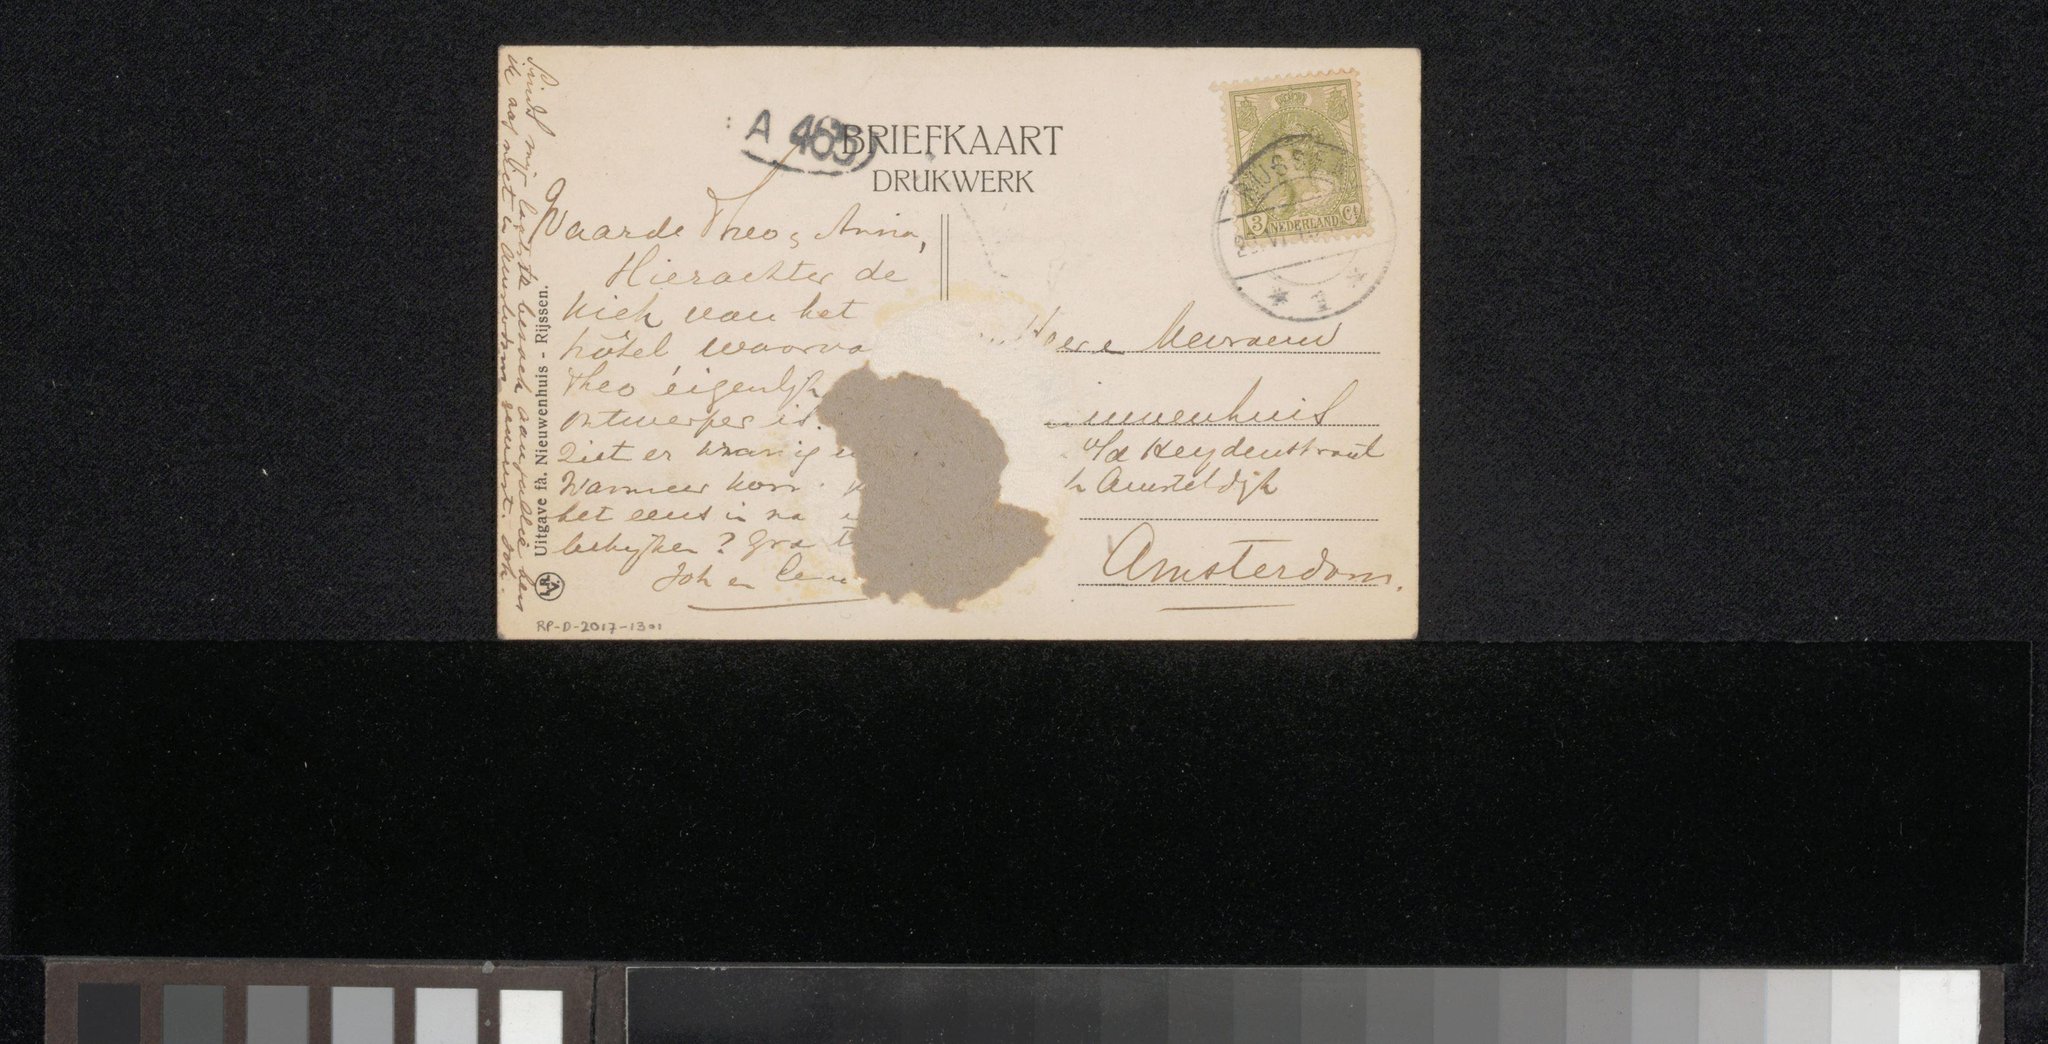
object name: postcard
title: Briefkaarten aan Theo Nieuwenhuis en mevrouw Nieuwenhuis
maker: Anonymous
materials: cardboard, ink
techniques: photograph, pen, writing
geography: rijssen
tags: print maker, draughtsman, theo nieuwenhuis, architecture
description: De briefkaarten zijn op een karton geplakt geweest. Dit karton wordt bij de briefkaarten bewaard en bevat een aantekening van Theo Nieuwenhuis.